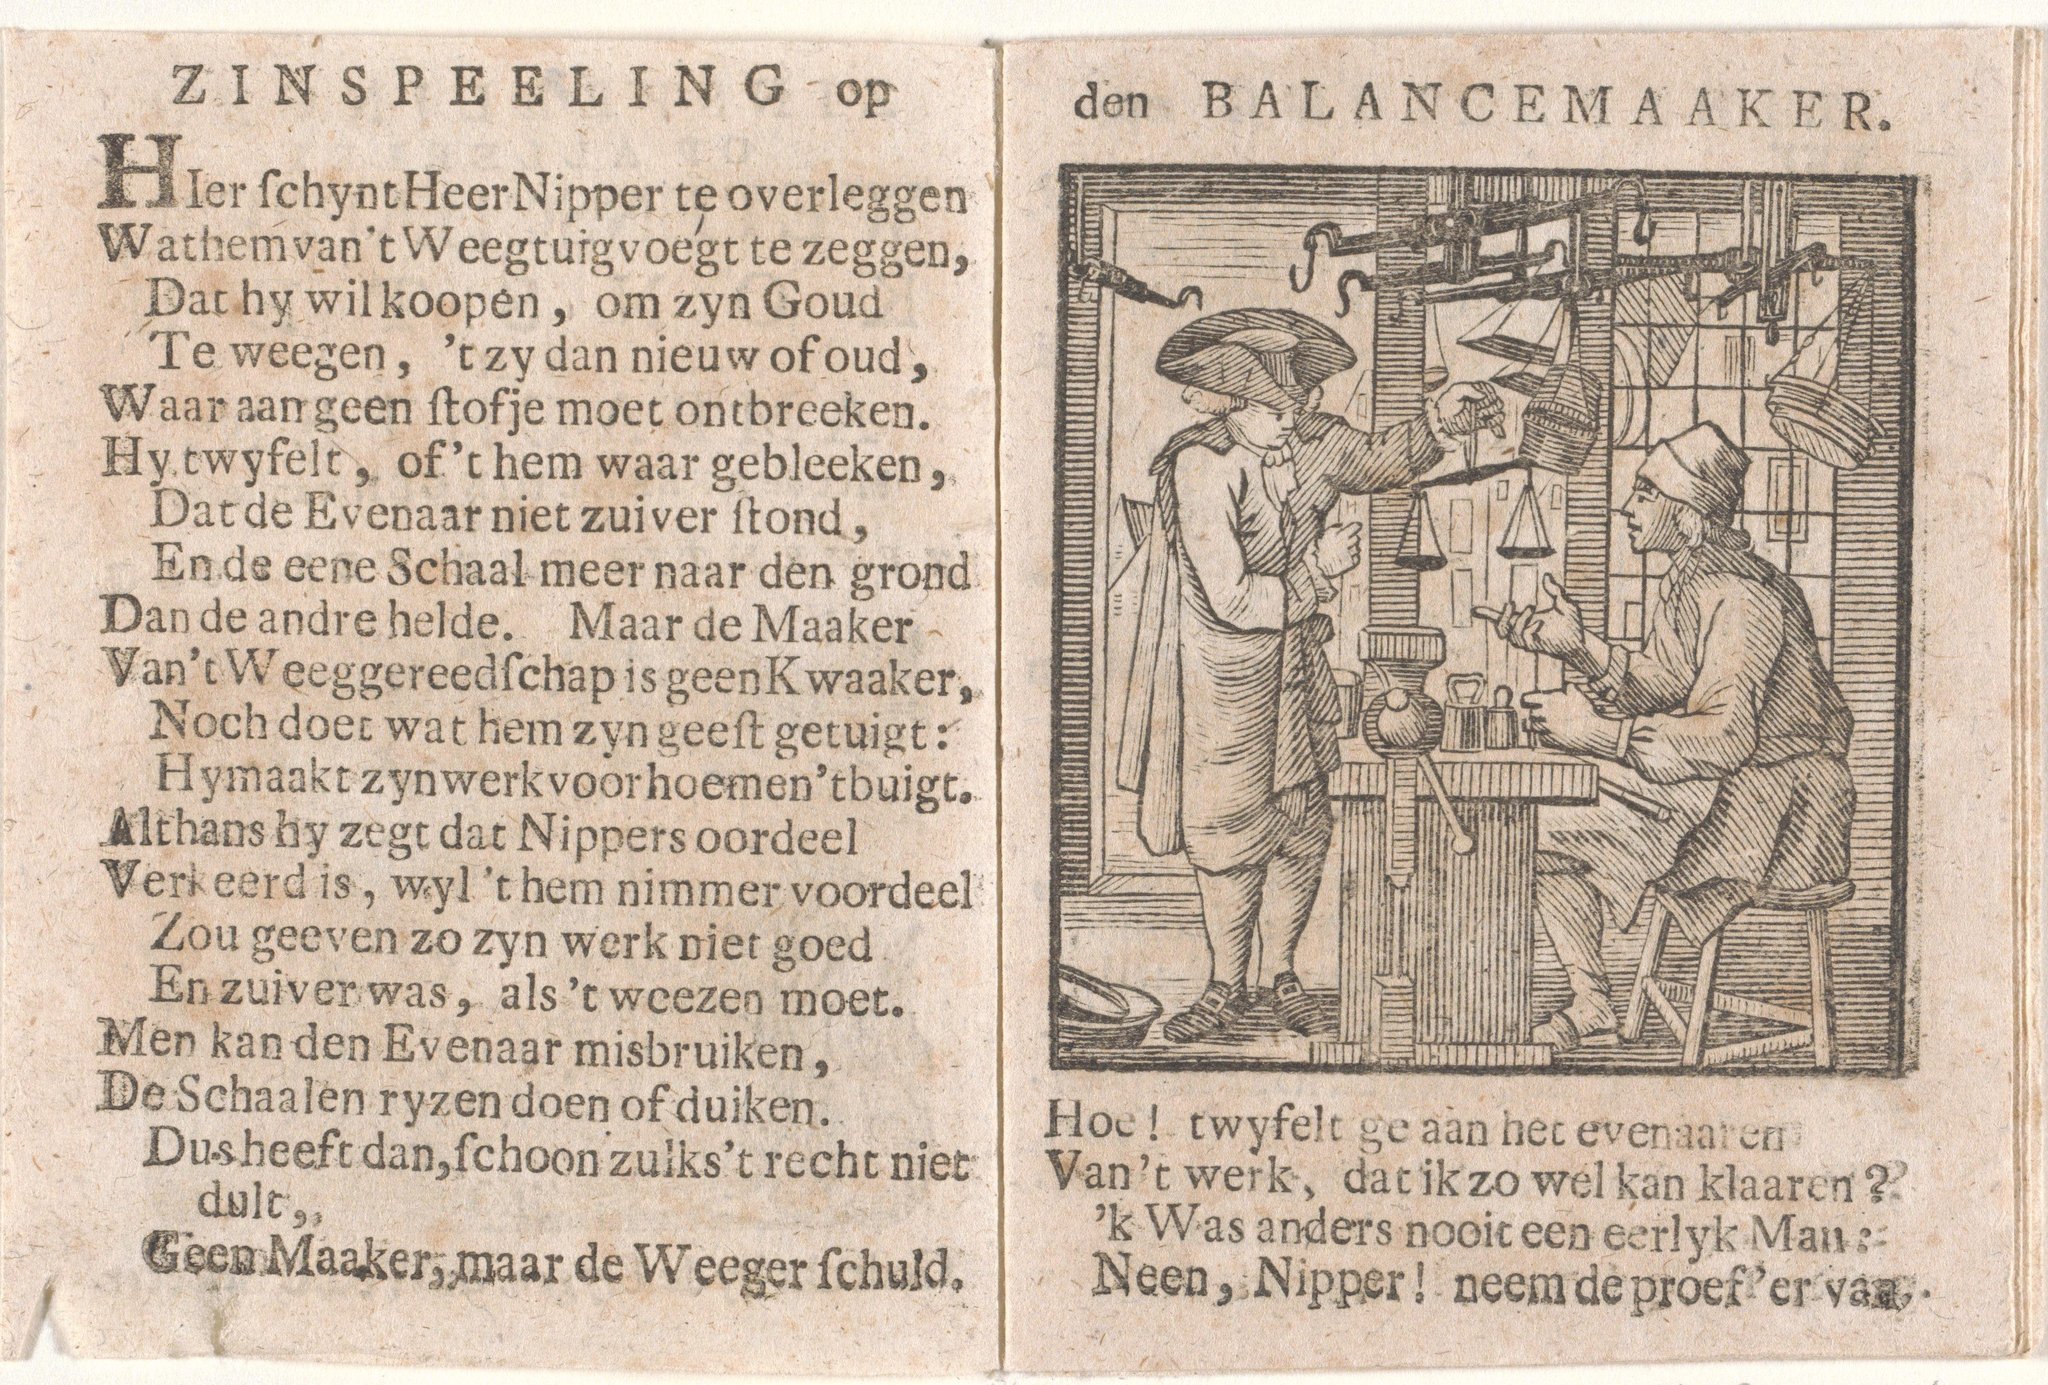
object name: print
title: Zinspeeling op den balancemaaker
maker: hendrik numan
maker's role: draughtsman, print maker, publisher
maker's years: 1736-1788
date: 1786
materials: paper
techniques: letterpress printing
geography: haarlem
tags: scales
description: Prent uit: Zinspeelingen op allerlei wetenschappen, konsten en ambachten: Continuation 17. Amsterdam: erven weduwe Cornelis Stichter, 1786.